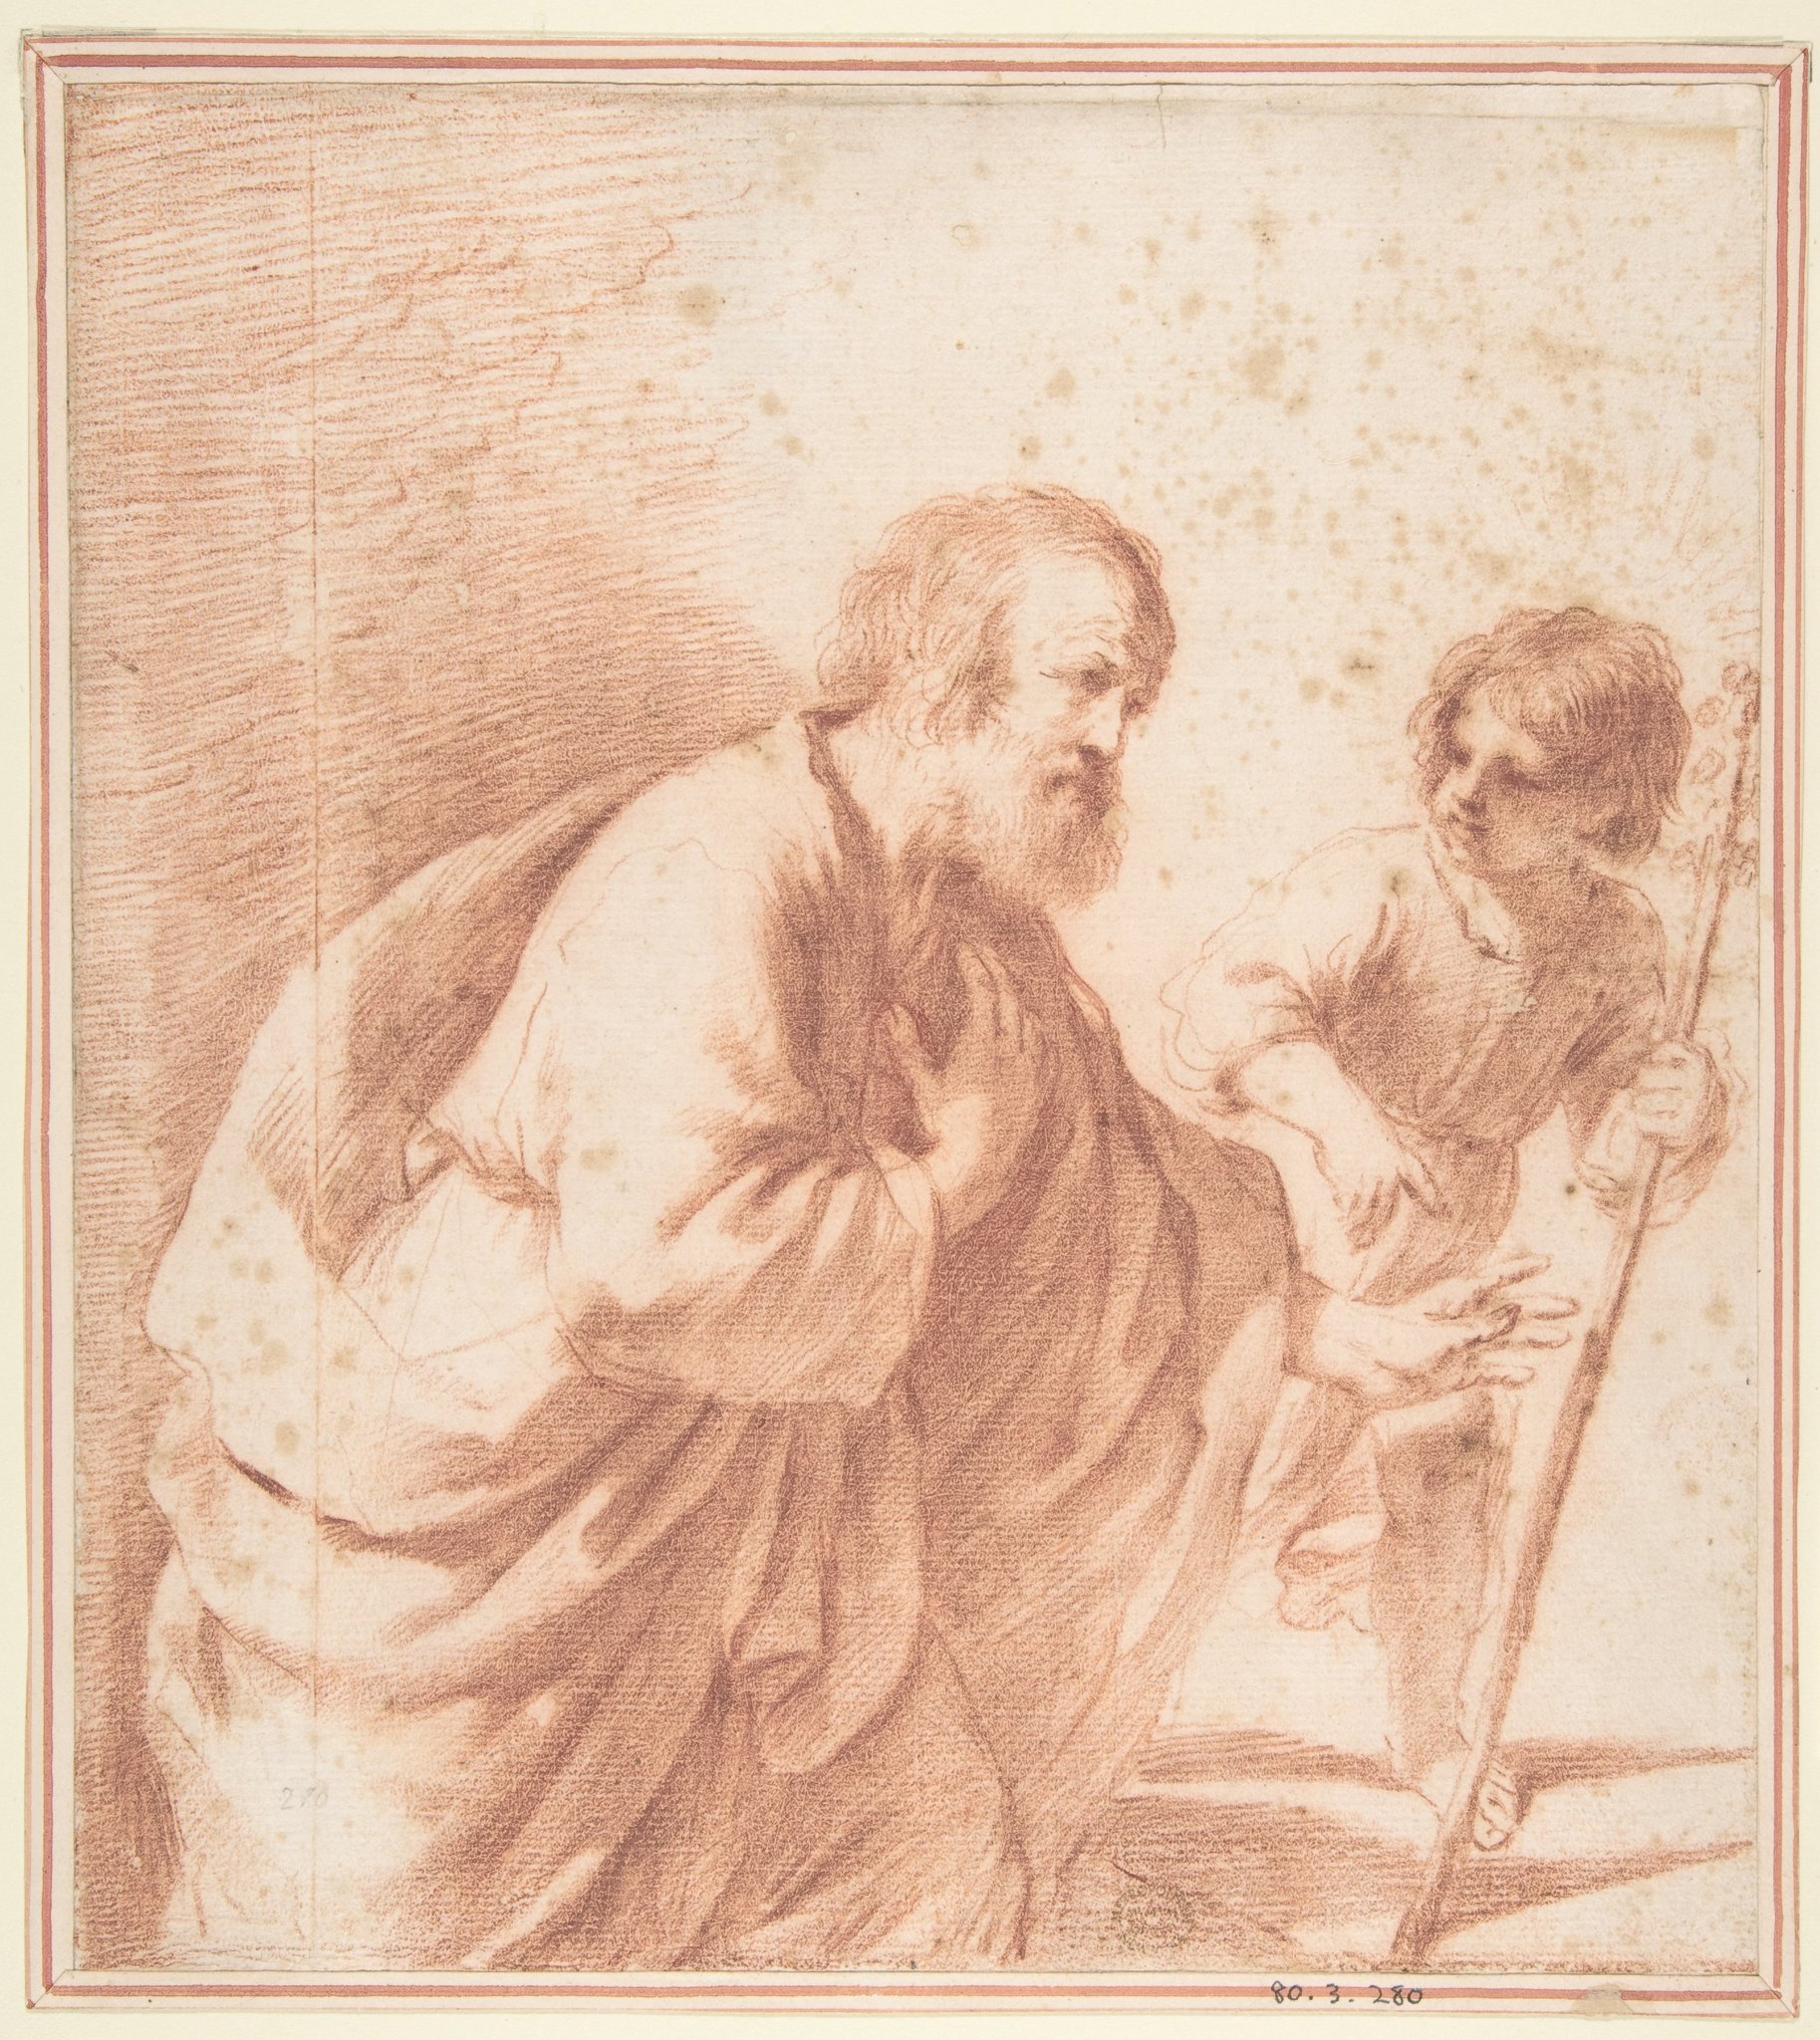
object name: drawing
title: Saint Joseph Seen with his Flowering Staff, which is Held by the Christ Child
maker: guercino (giovanni francesco barbieri)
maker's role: artist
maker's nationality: italian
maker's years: 1591-1666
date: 1591-1666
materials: chalk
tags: christ,saint joseph